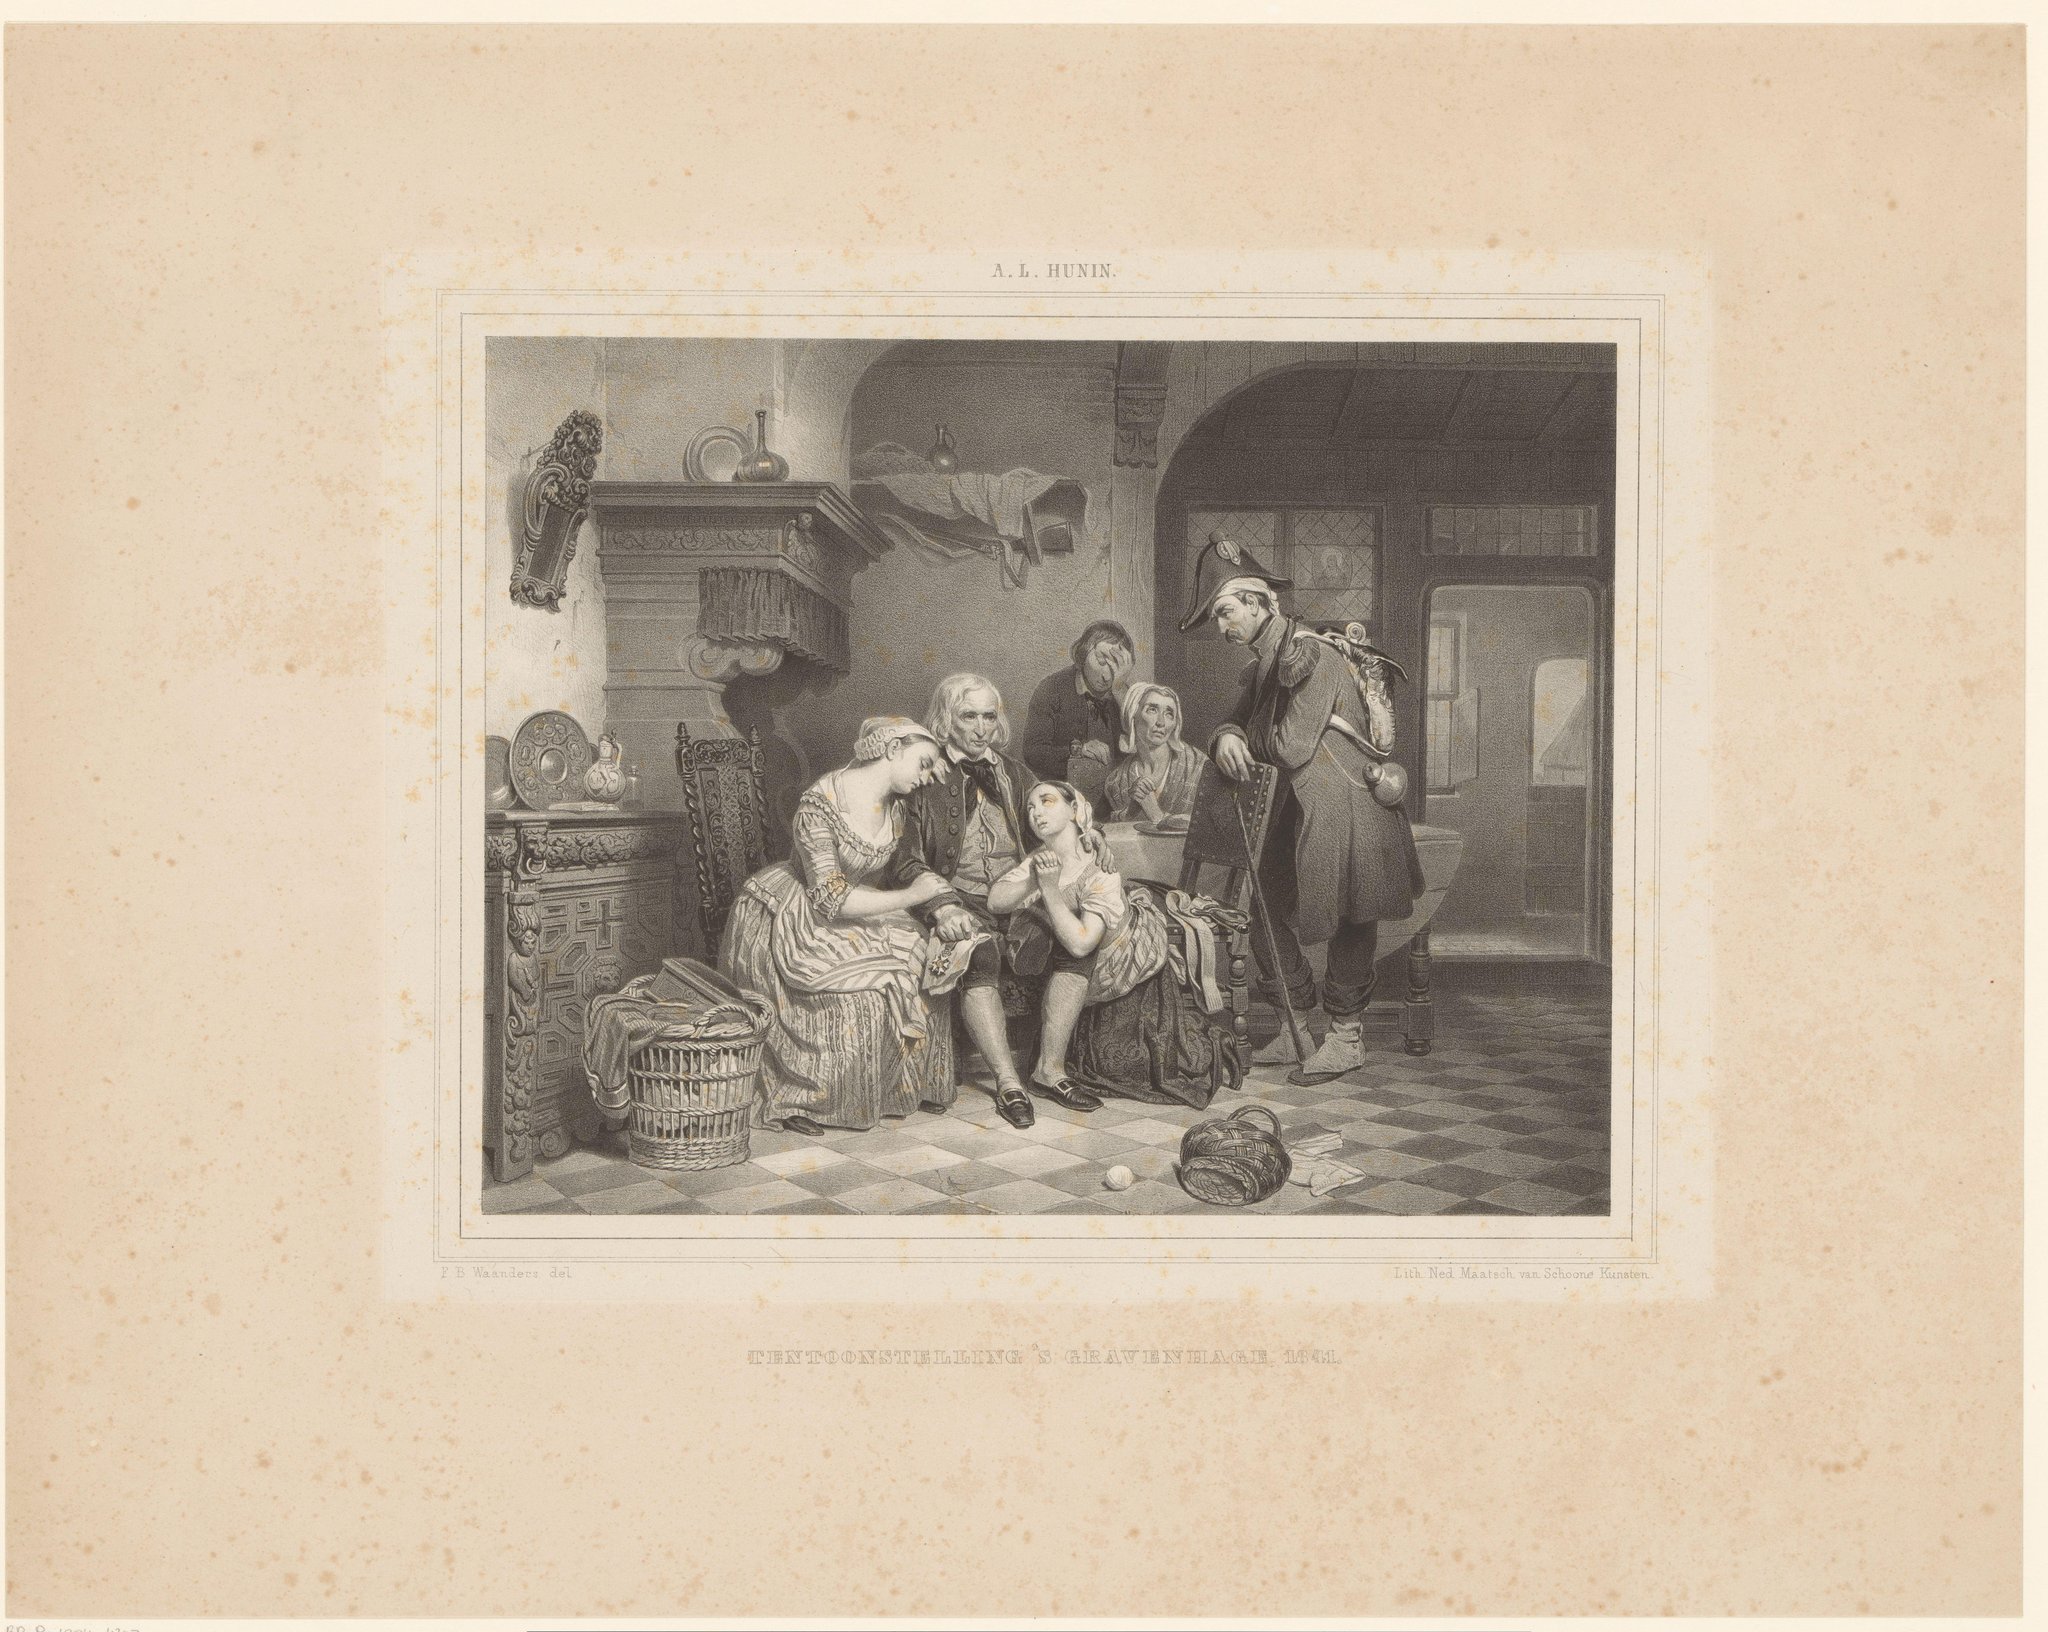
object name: print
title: Tentoonstelling 's Gravenhage, 1841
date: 1841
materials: paper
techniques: lithograph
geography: the hague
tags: receiving bad news, bad message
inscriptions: collector's mark: Lugt 2228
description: Een soldaat brengt bericht van het slagveld aan de familieleden van een gesneuvelde kameraad.